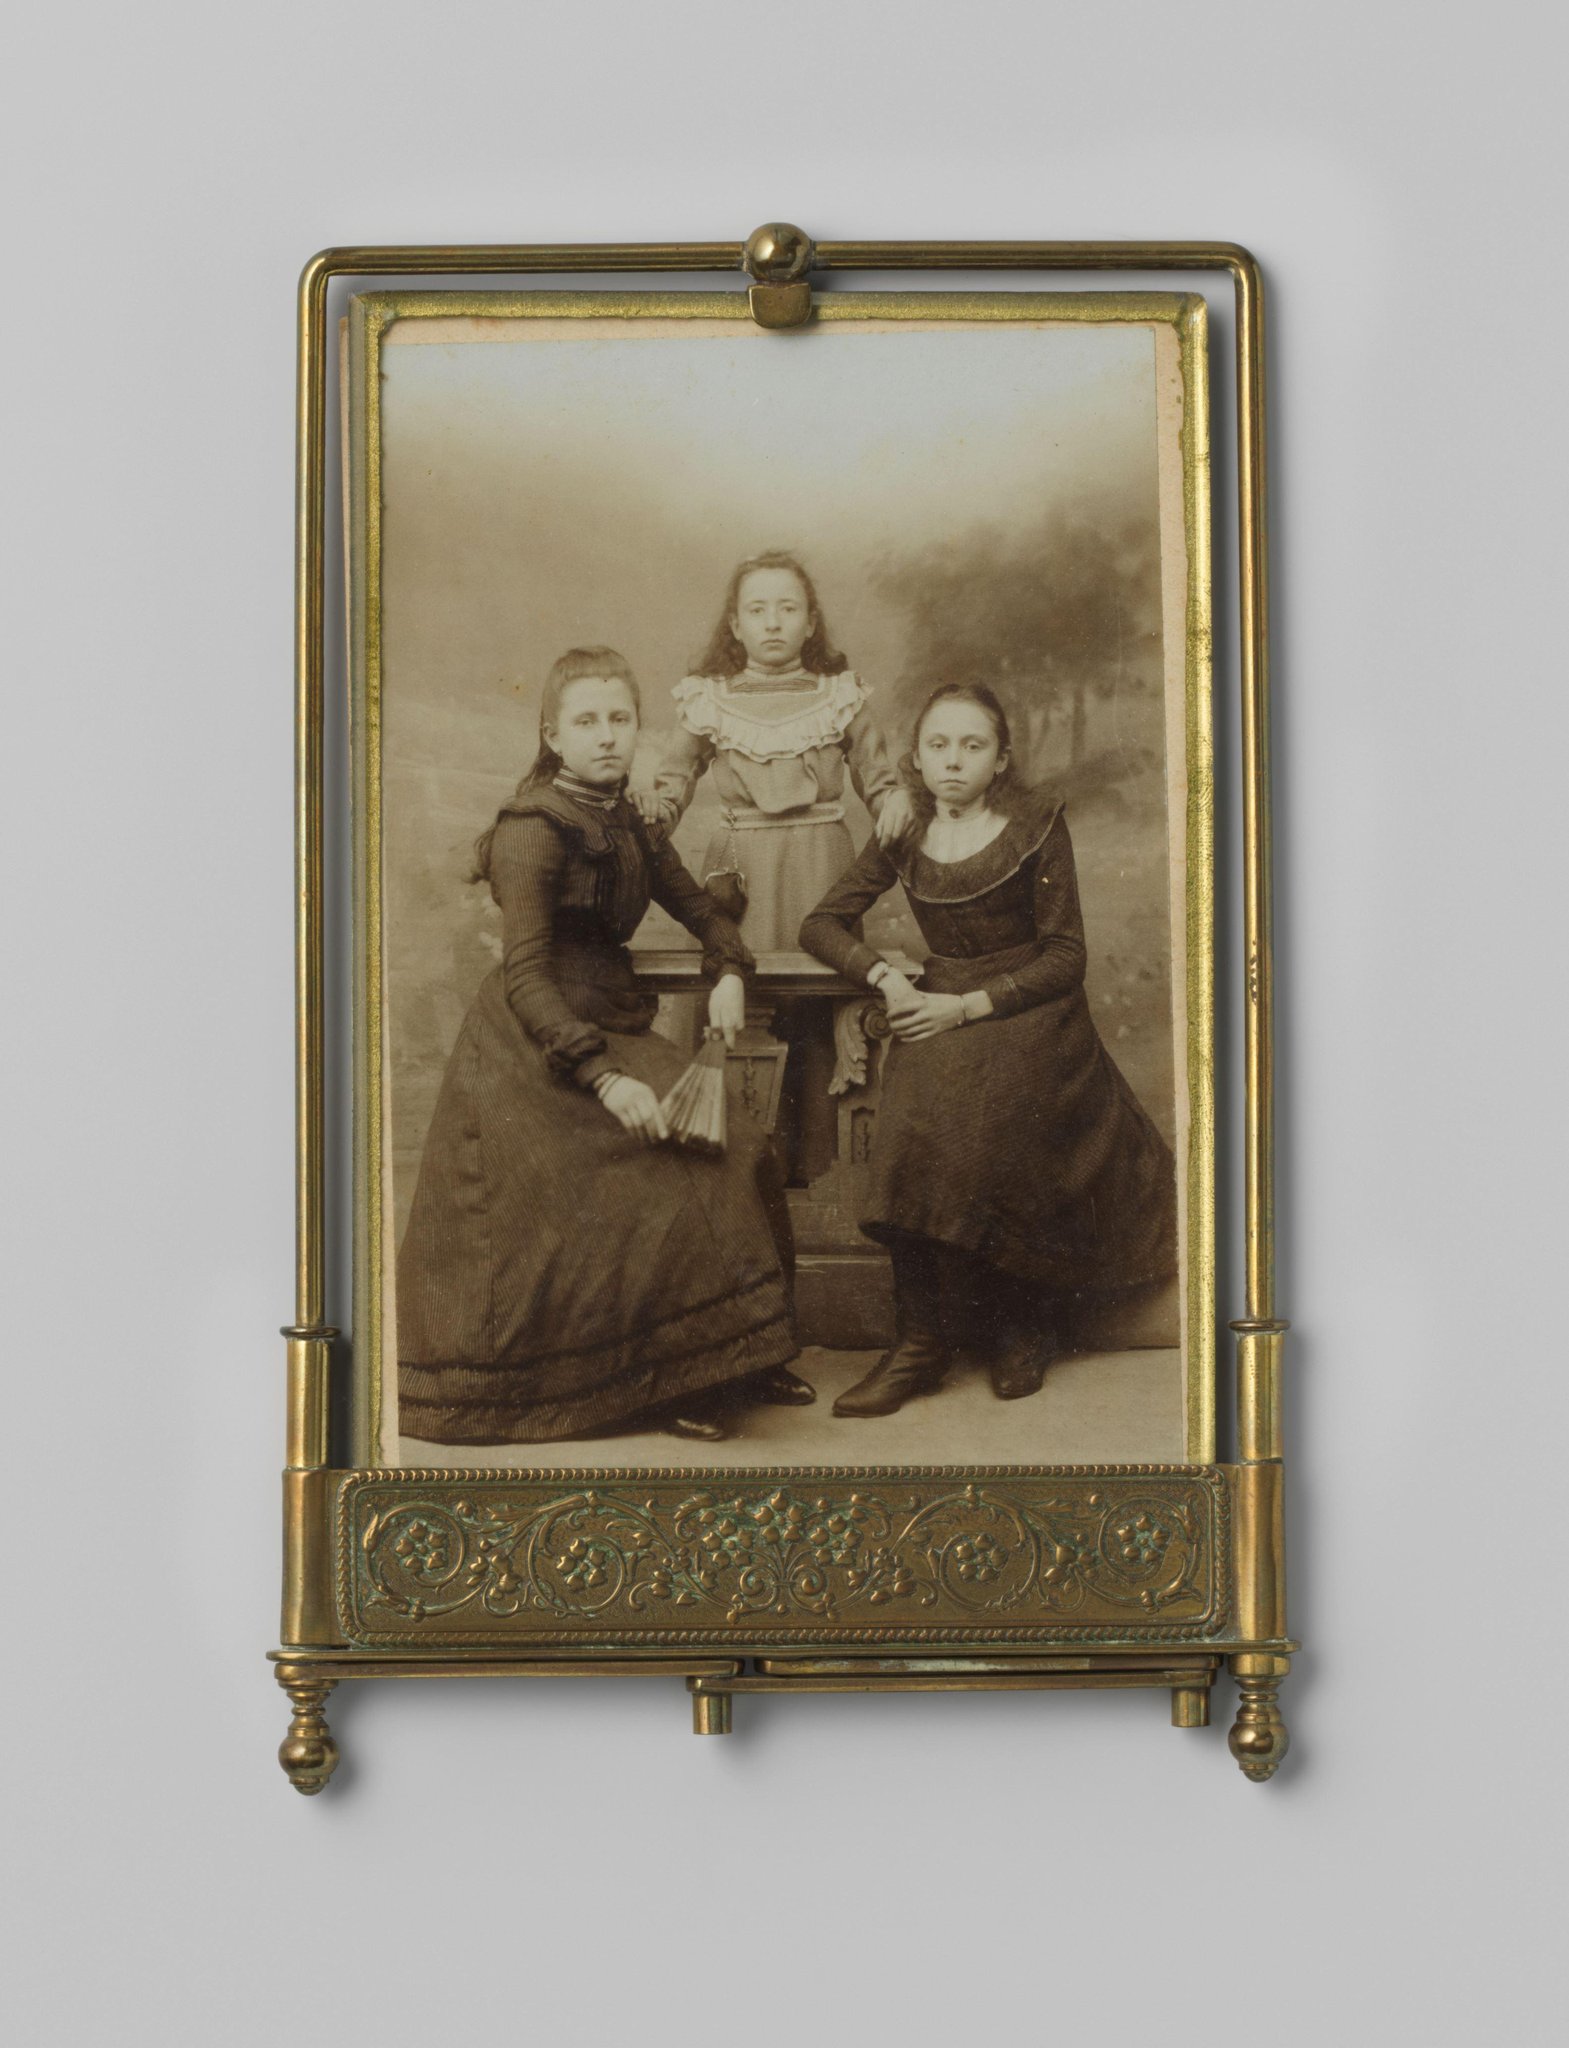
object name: cabinet photograph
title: Portret van drie onbekende meisjes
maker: Anonymous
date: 1880-1900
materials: paper, cardboard, glass, metal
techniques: gelatin silver print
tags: girl (child between toddler and youth), anonymous historical person portrayed